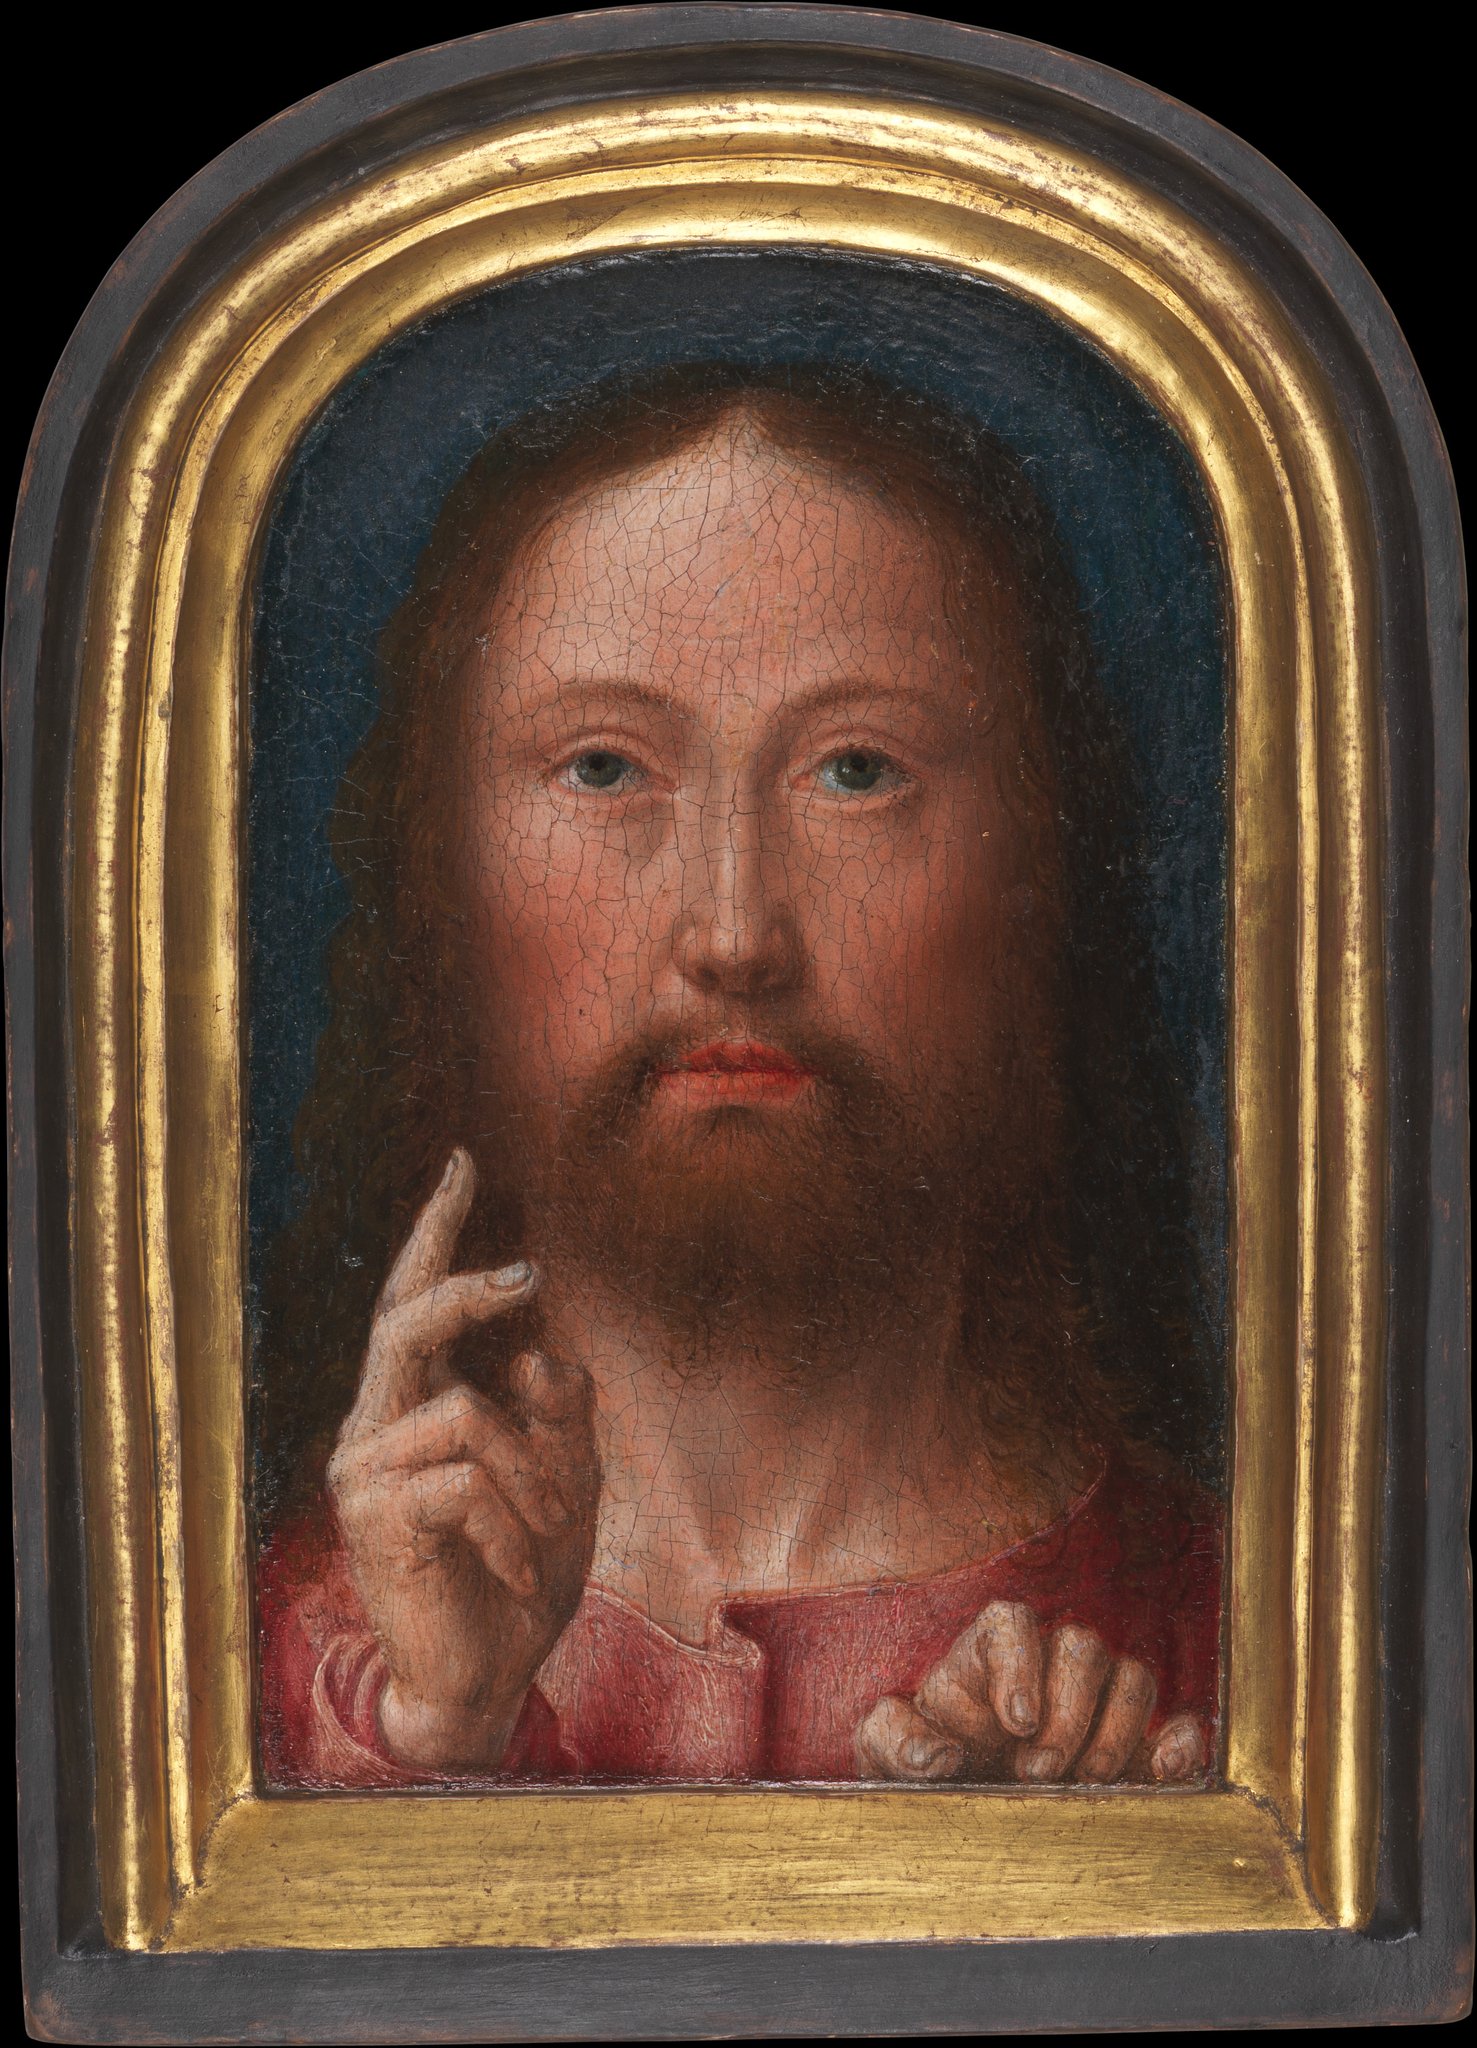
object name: painting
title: Christ Blessing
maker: gerard david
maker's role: artist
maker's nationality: netherlandish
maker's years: 1455-1523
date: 1500-1505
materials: oil, wood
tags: christ